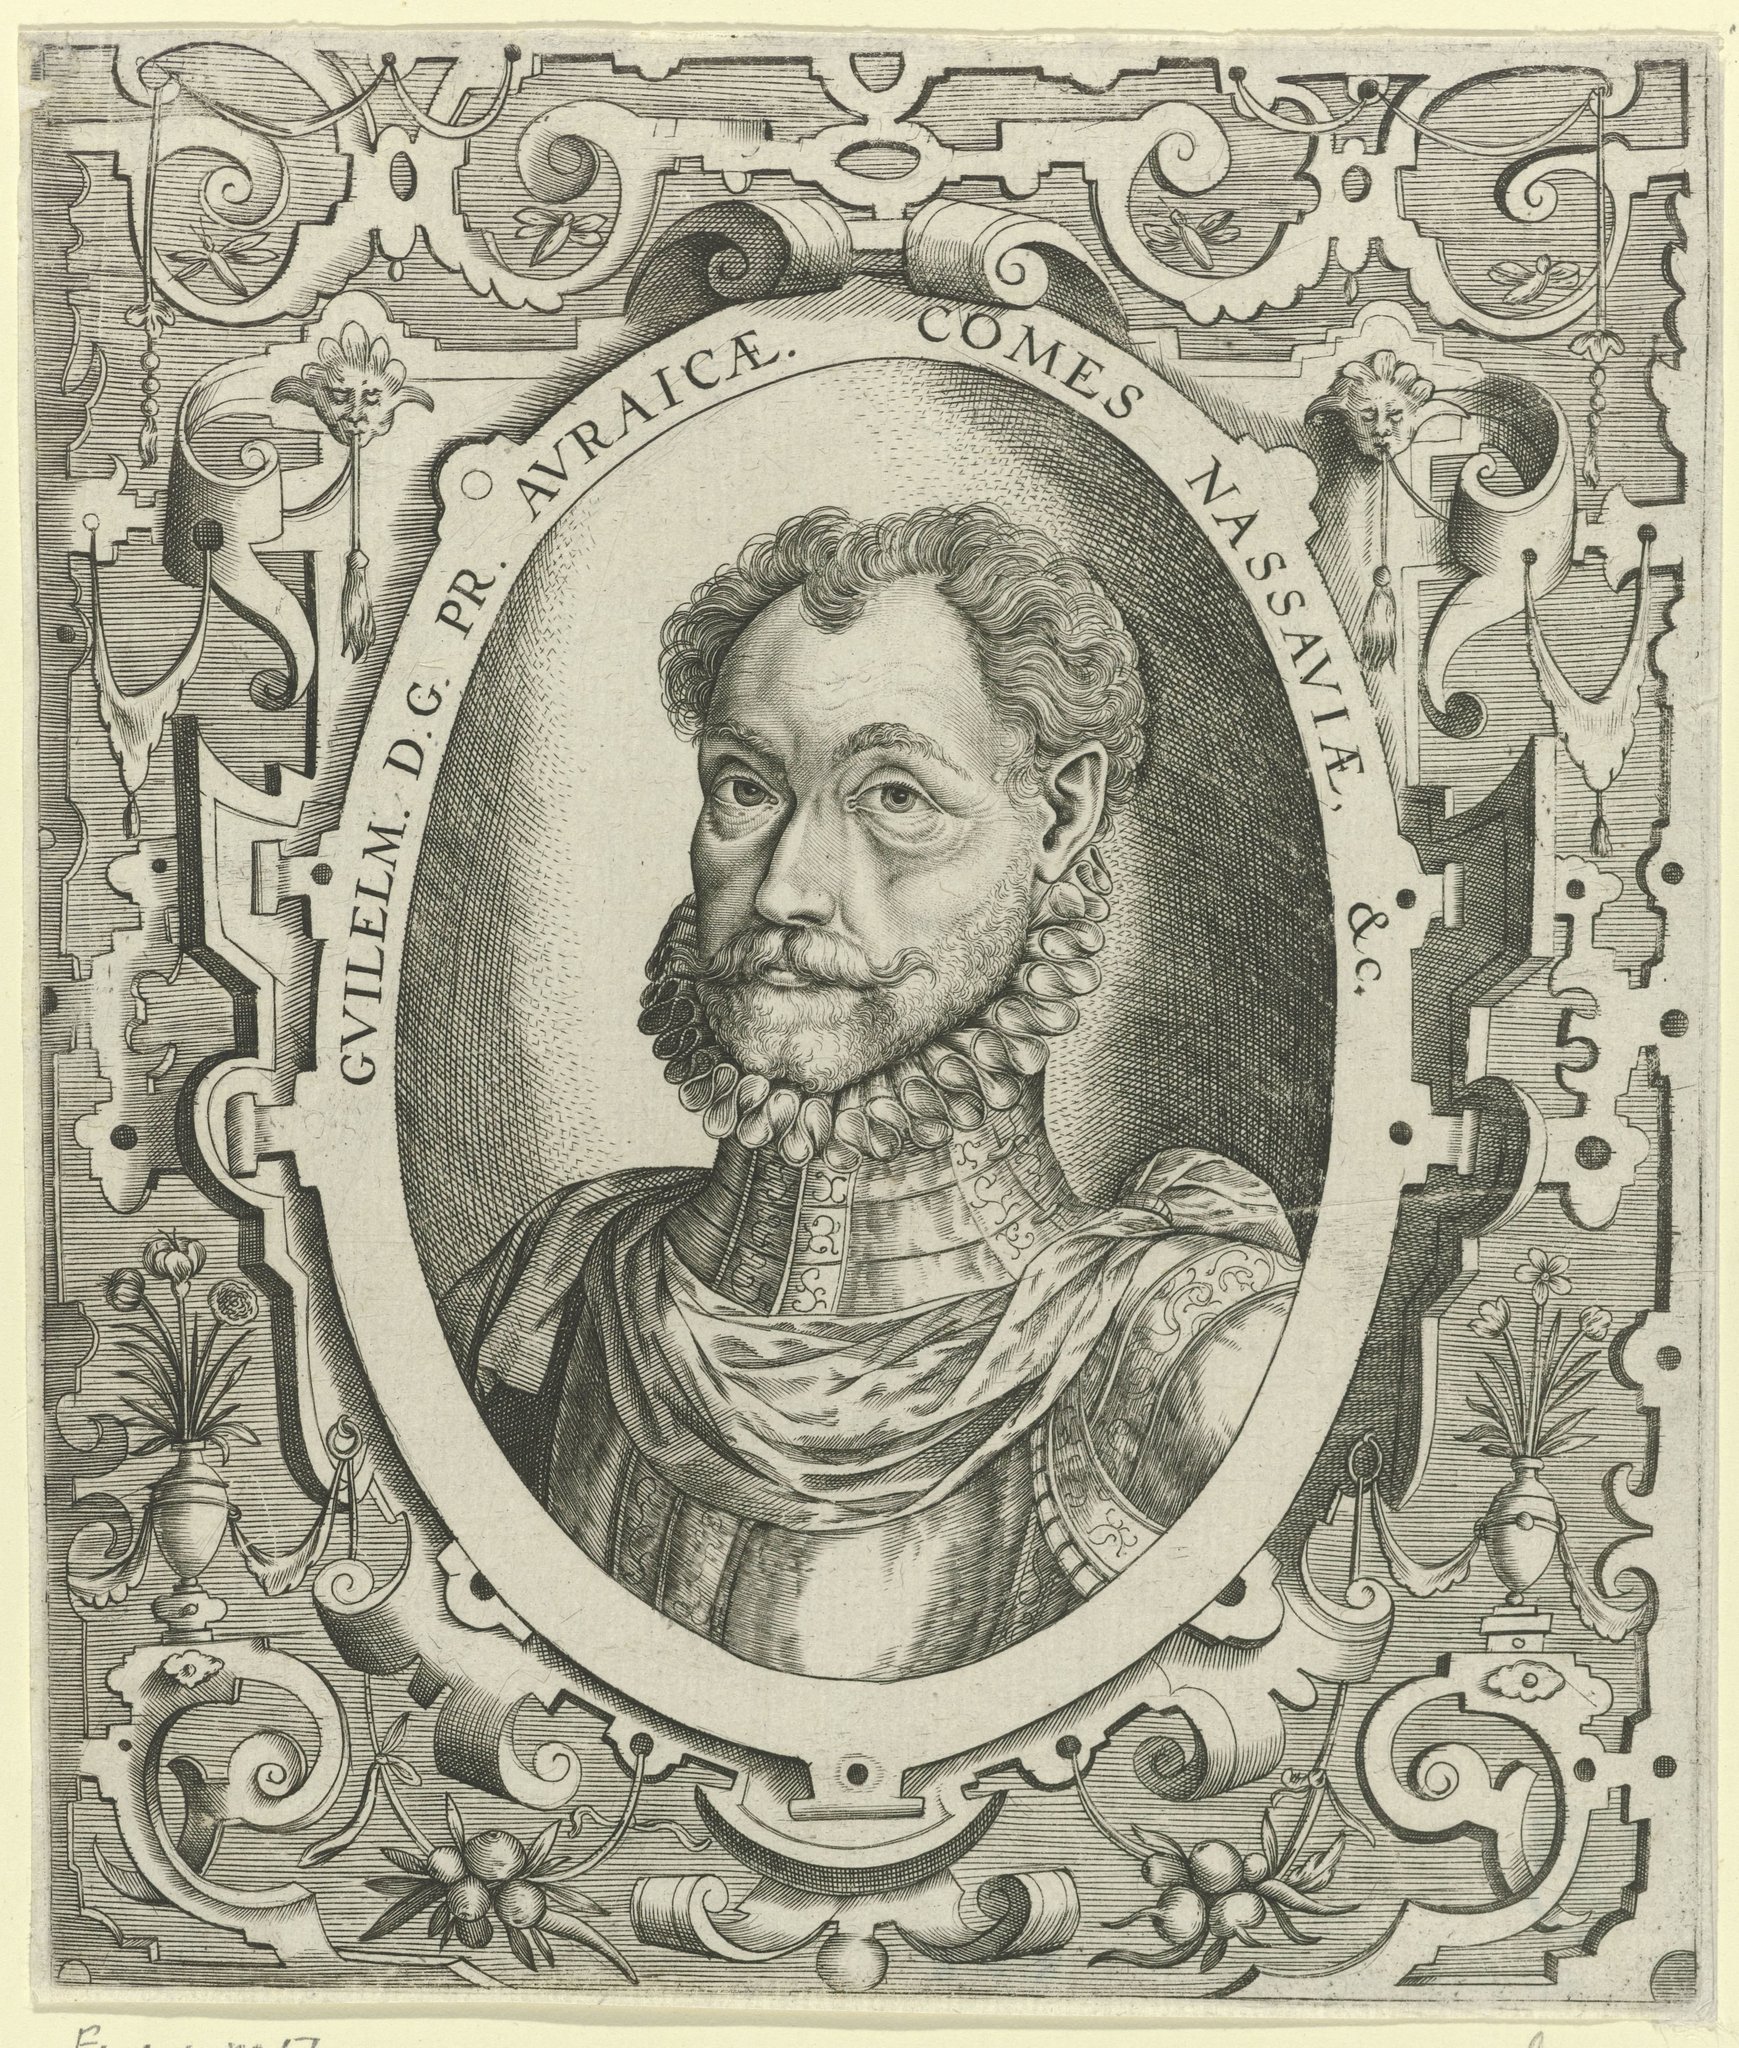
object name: print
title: Portret van Willem I, prins van Oranje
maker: Anonymous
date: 1600-1699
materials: paper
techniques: engraving, etching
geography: low countries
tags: delft, william i (prince of orange)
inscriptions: collector's mark: Lugt 2233, collector's mark: Lugt 963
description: De hier vermelde titel verwijst naar de hoogst verkregen titel van de geportretteerde, niet per se naar de titel die de geportretteerde op deze voorstelling draagt.